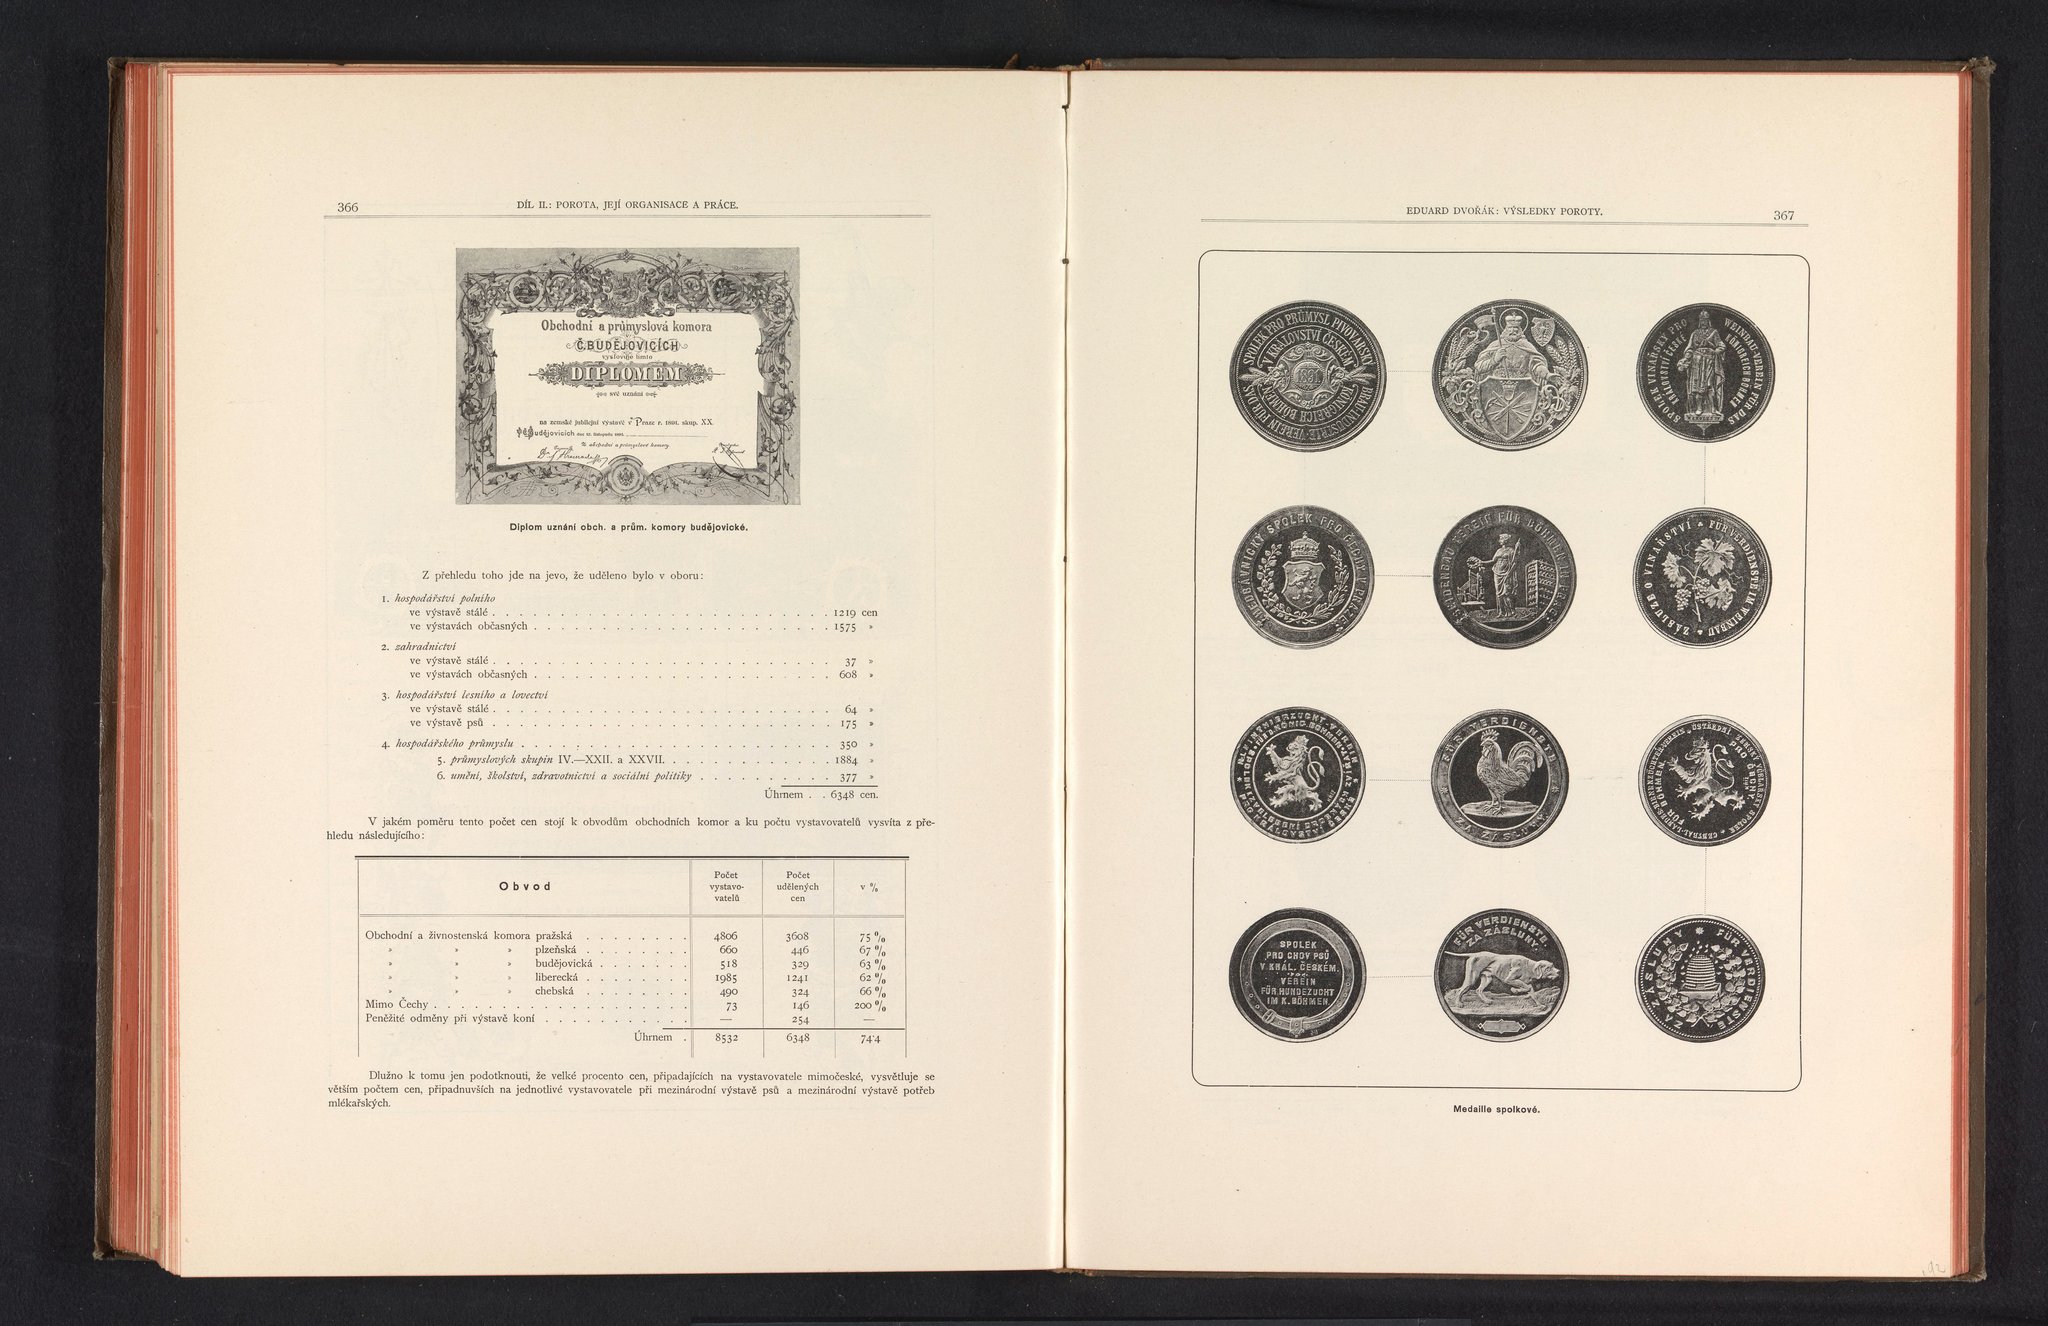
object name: photomechanical print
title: Twaalf medailles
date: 1891-1893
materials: paper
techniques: autotype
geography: prague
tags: memorial medal